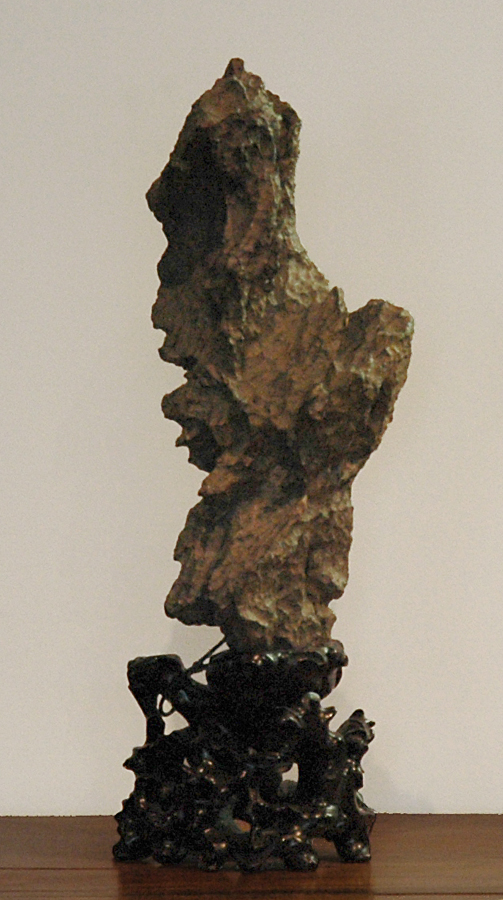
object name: scholar's rock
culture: chinese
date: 1701-1900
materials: limestone, wood